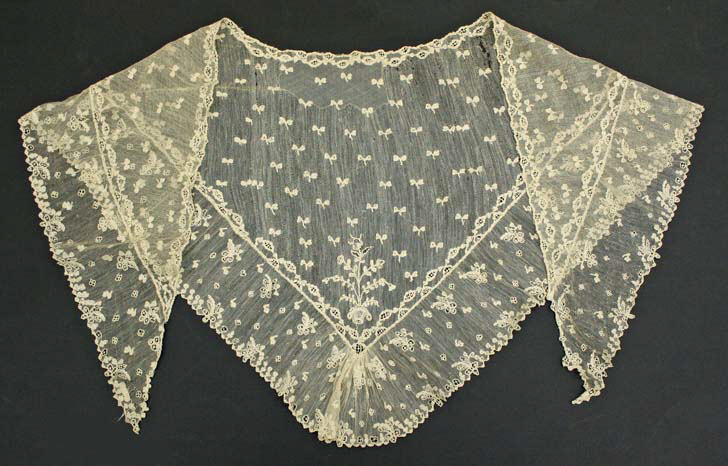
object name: fichu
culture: italian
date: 1701-1900